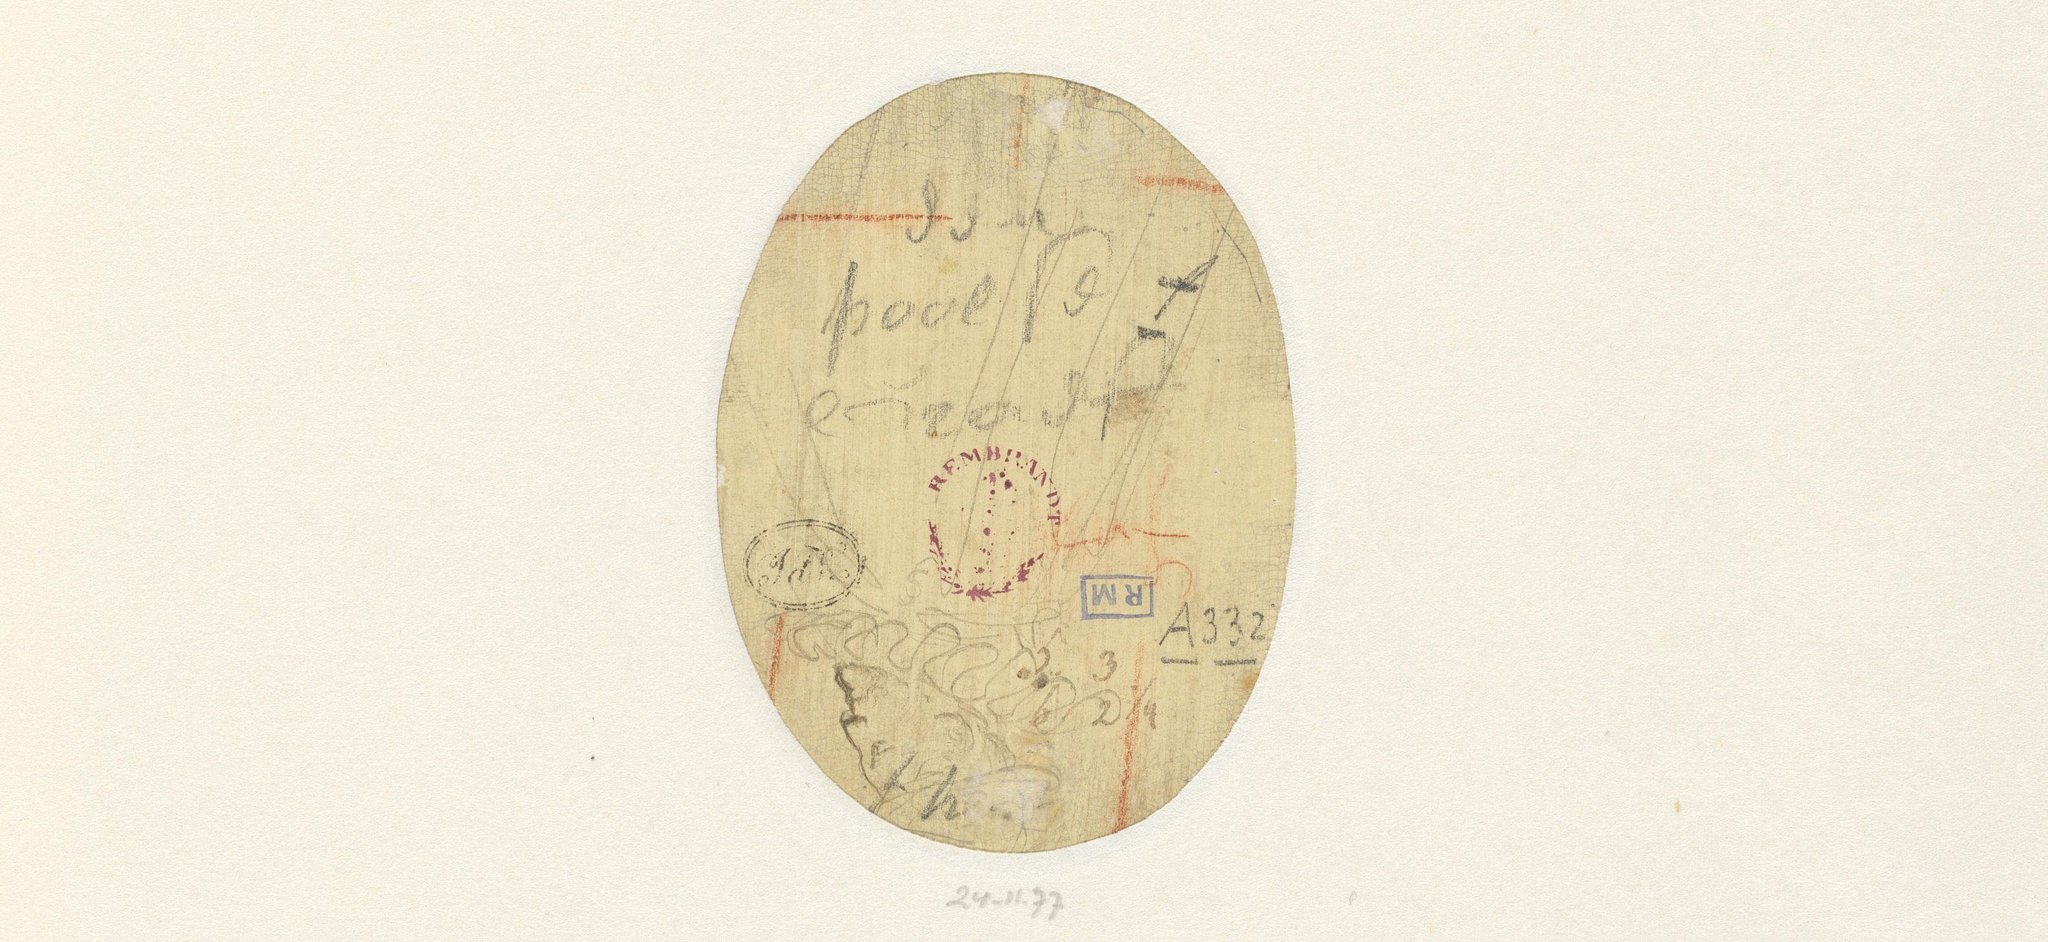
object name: drawing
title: Edelman (Stanislas Sobocki?)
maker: hendrick goltzius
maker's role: draughtsman, painter, print maker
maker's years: 1558-1617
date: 1583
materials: paper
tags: stanislas sobocki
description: Profielschets van een edelman, waarschijnlijk Stanislas Sobocki.